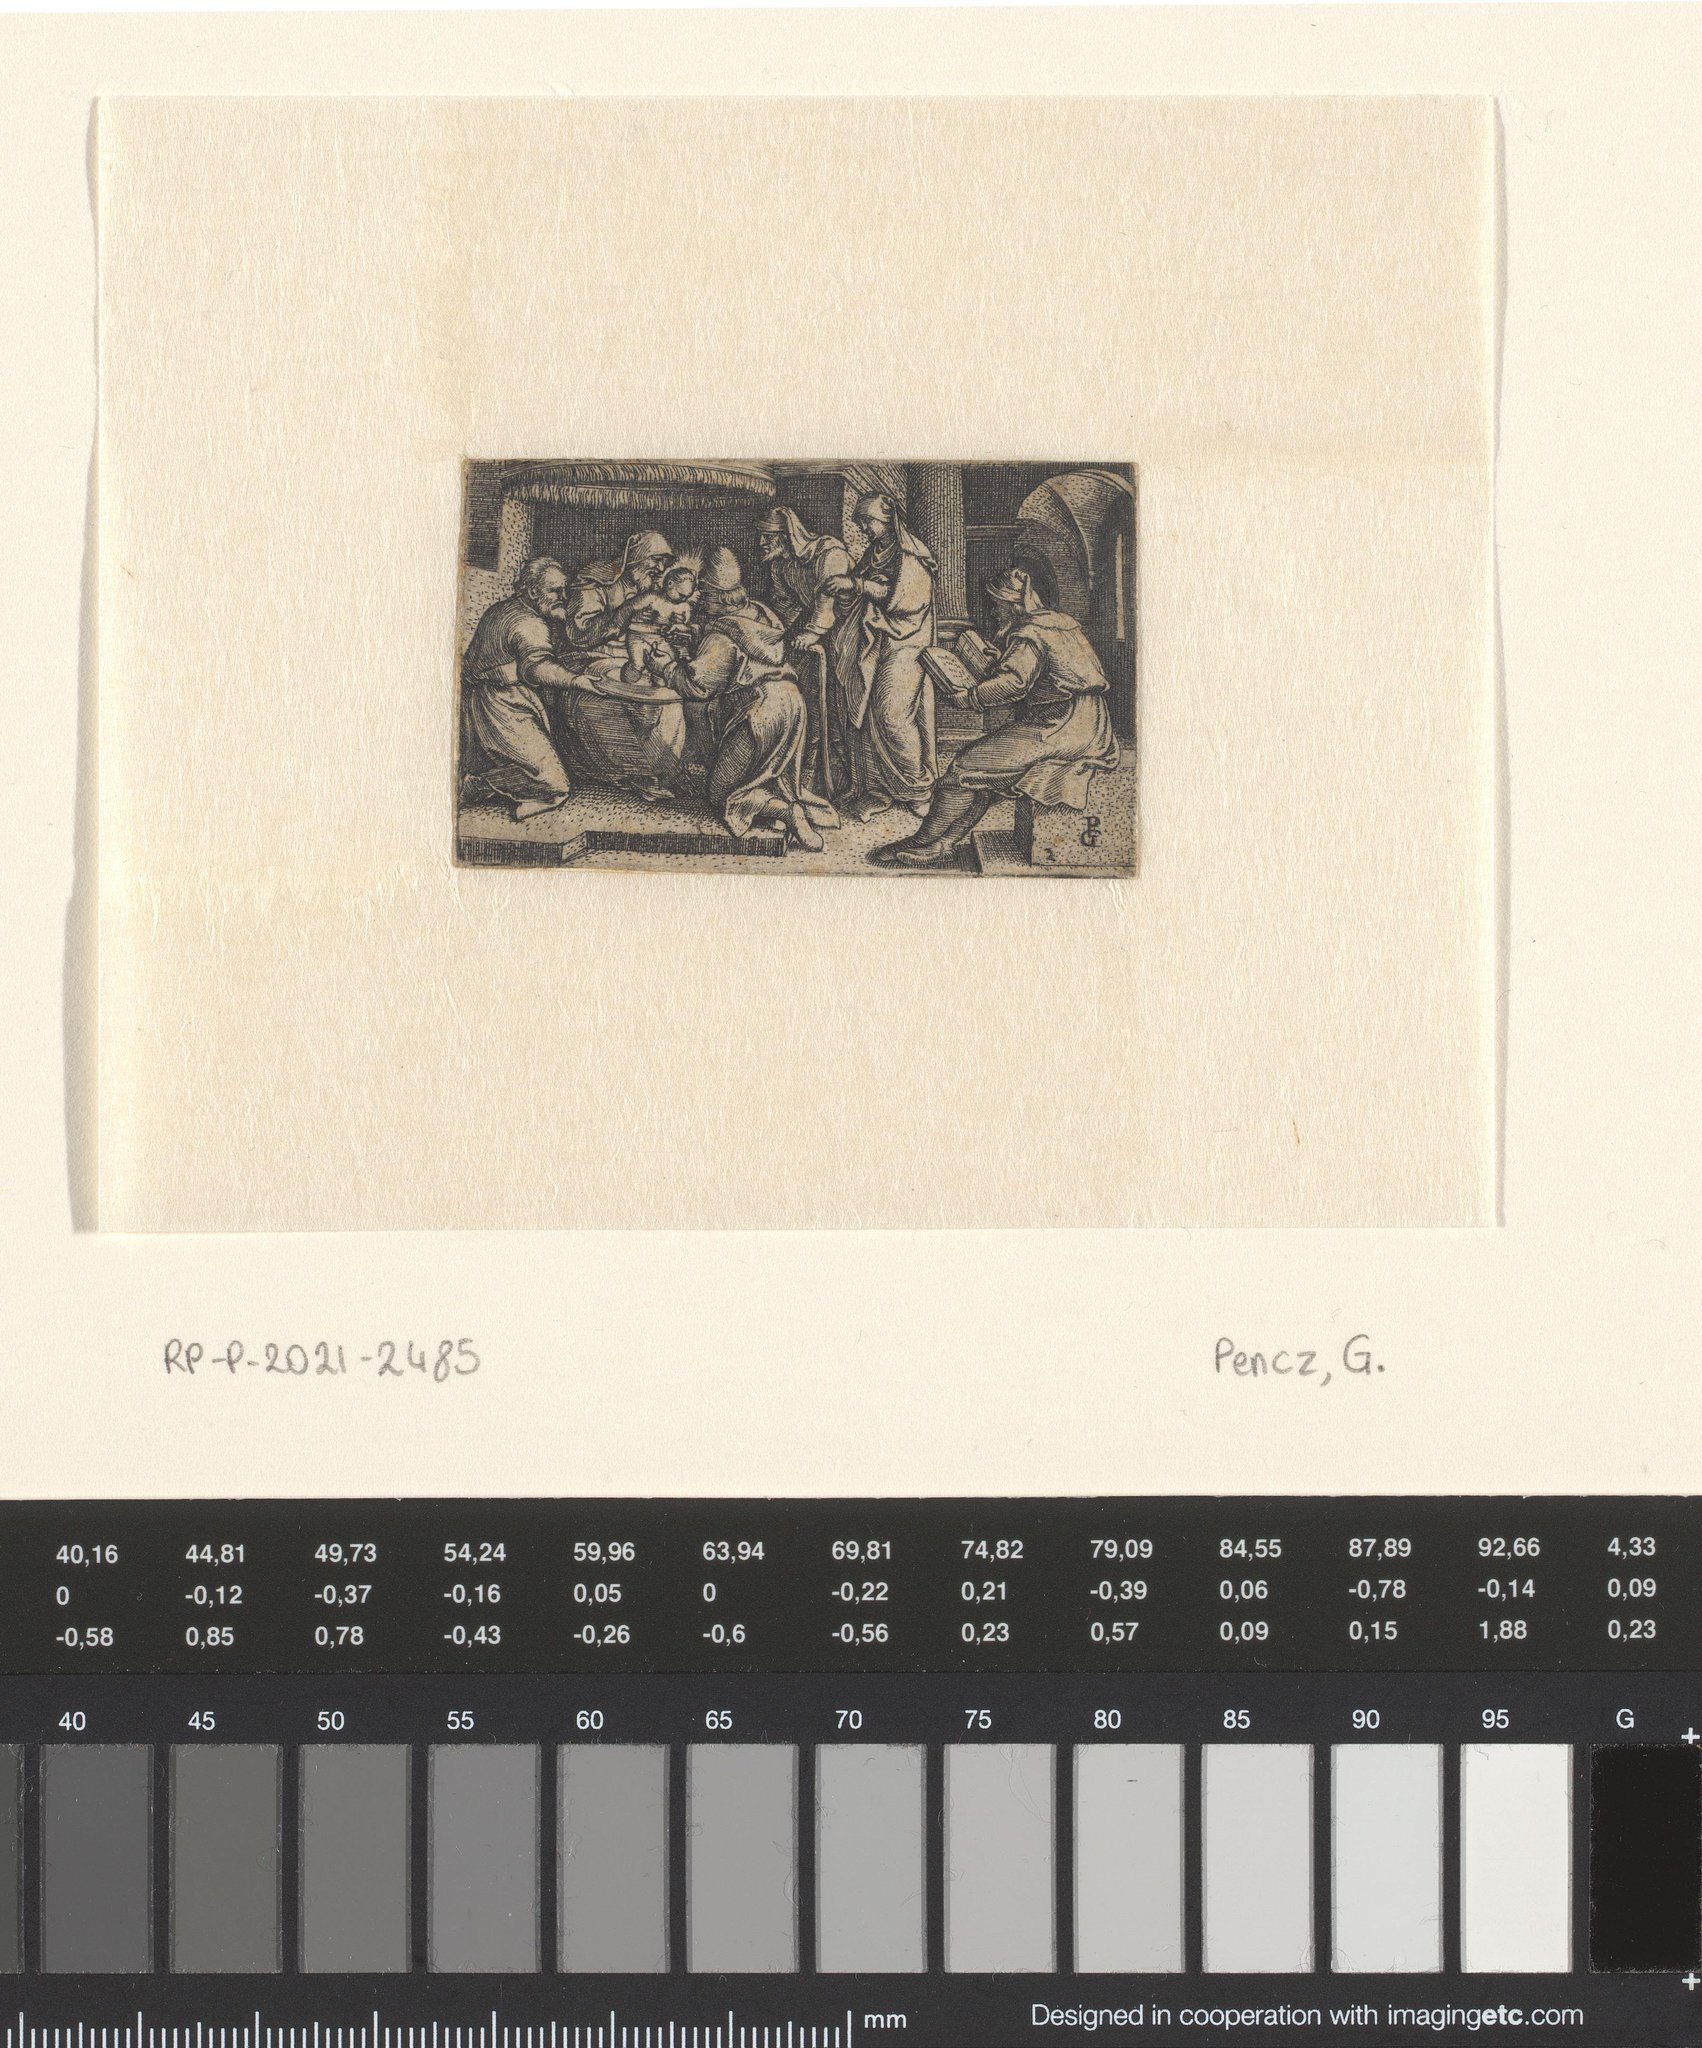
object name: print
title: Besnijdenis van Christus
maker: georg pencz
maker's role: draughtsman, painter, print maker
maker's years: 1500-1550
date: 1534-1535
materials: paper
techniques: engraving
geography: germany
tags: circumcision of the christ-child by the priest in the temple (luke 2:21)